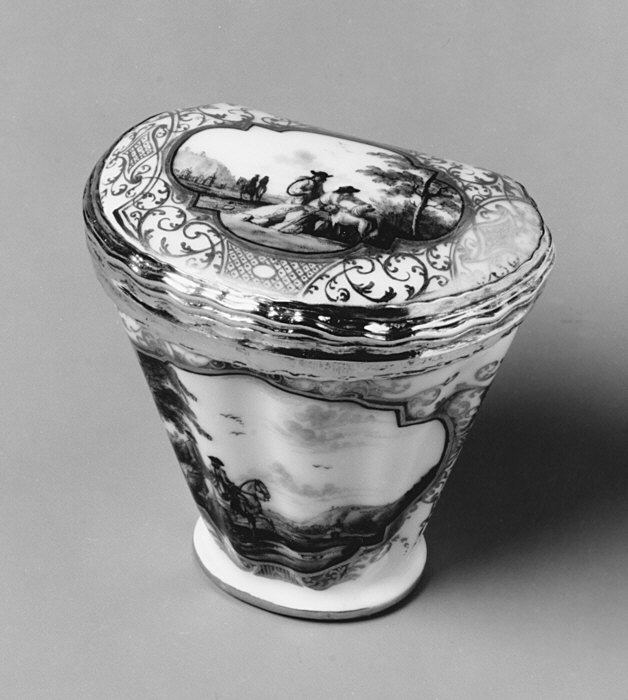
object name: snuffbox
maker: meissen manufactory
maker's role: manufactory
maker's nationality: german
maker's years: 1710-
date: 1740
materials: hard paste porcelain, silver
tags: human figures,horses,trees